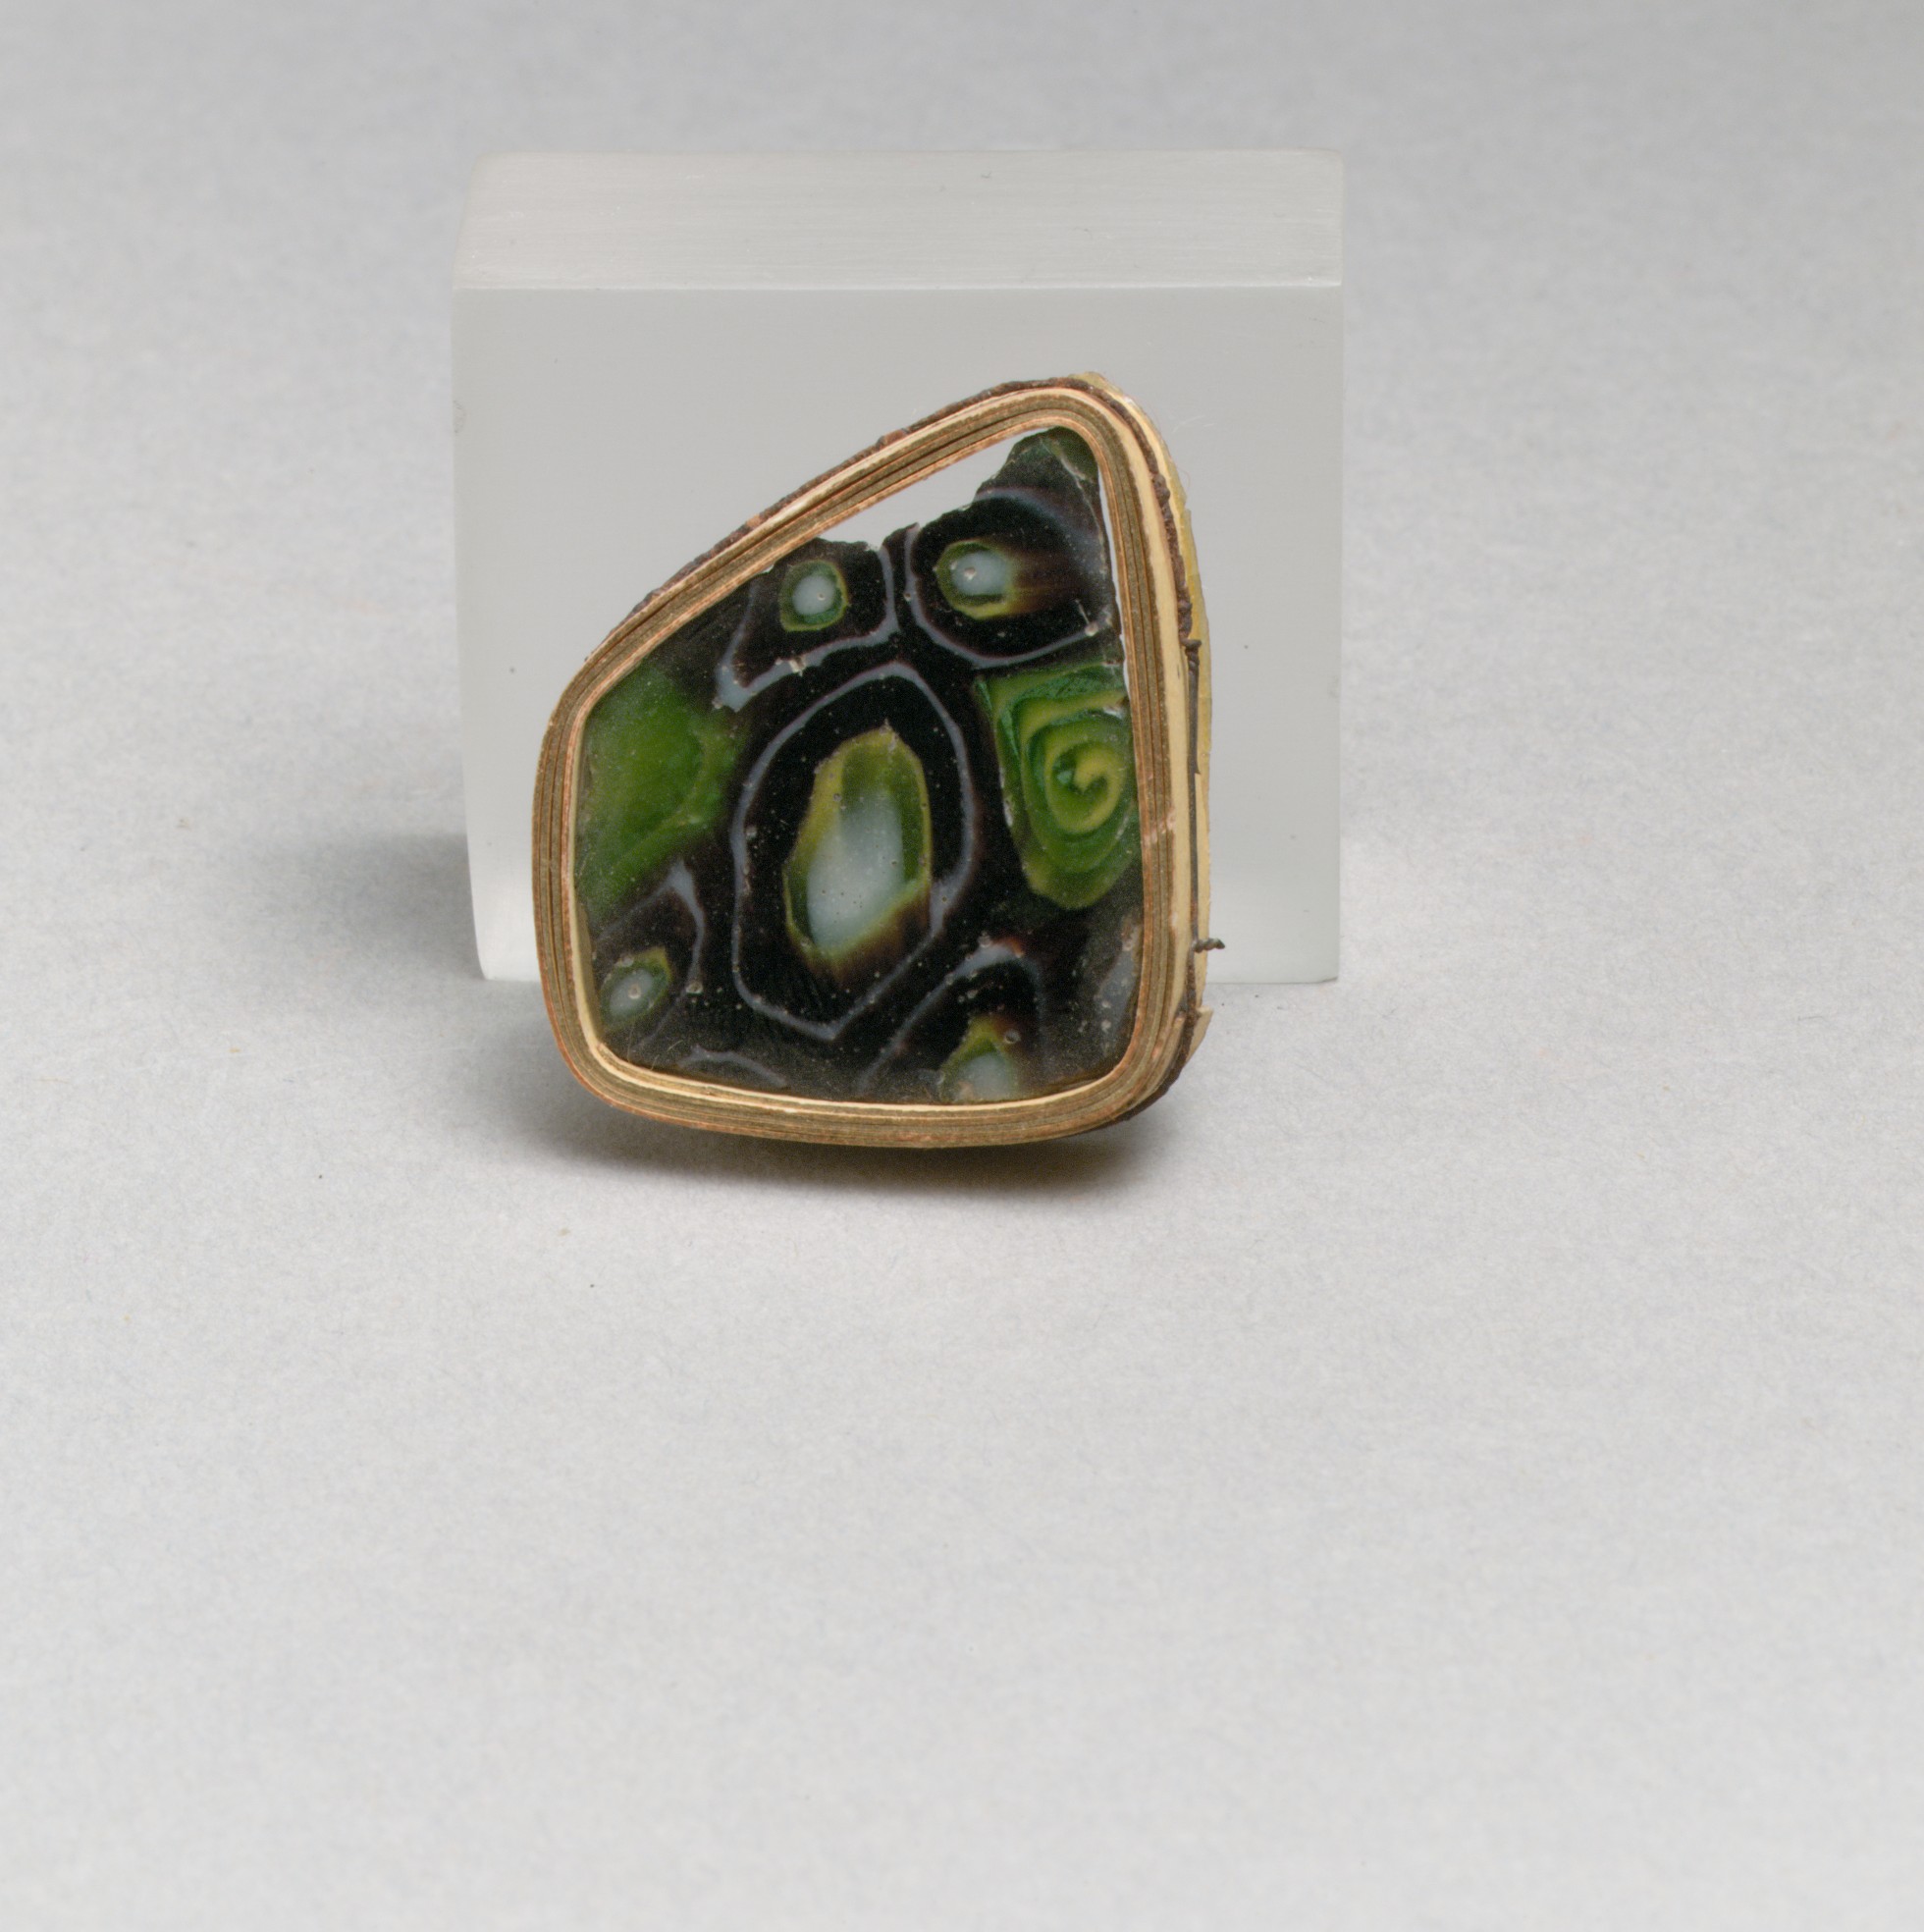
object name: fragment, mosaic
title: Glass mosaic fragment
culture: roman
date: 34 BCE-33 CE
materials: glass